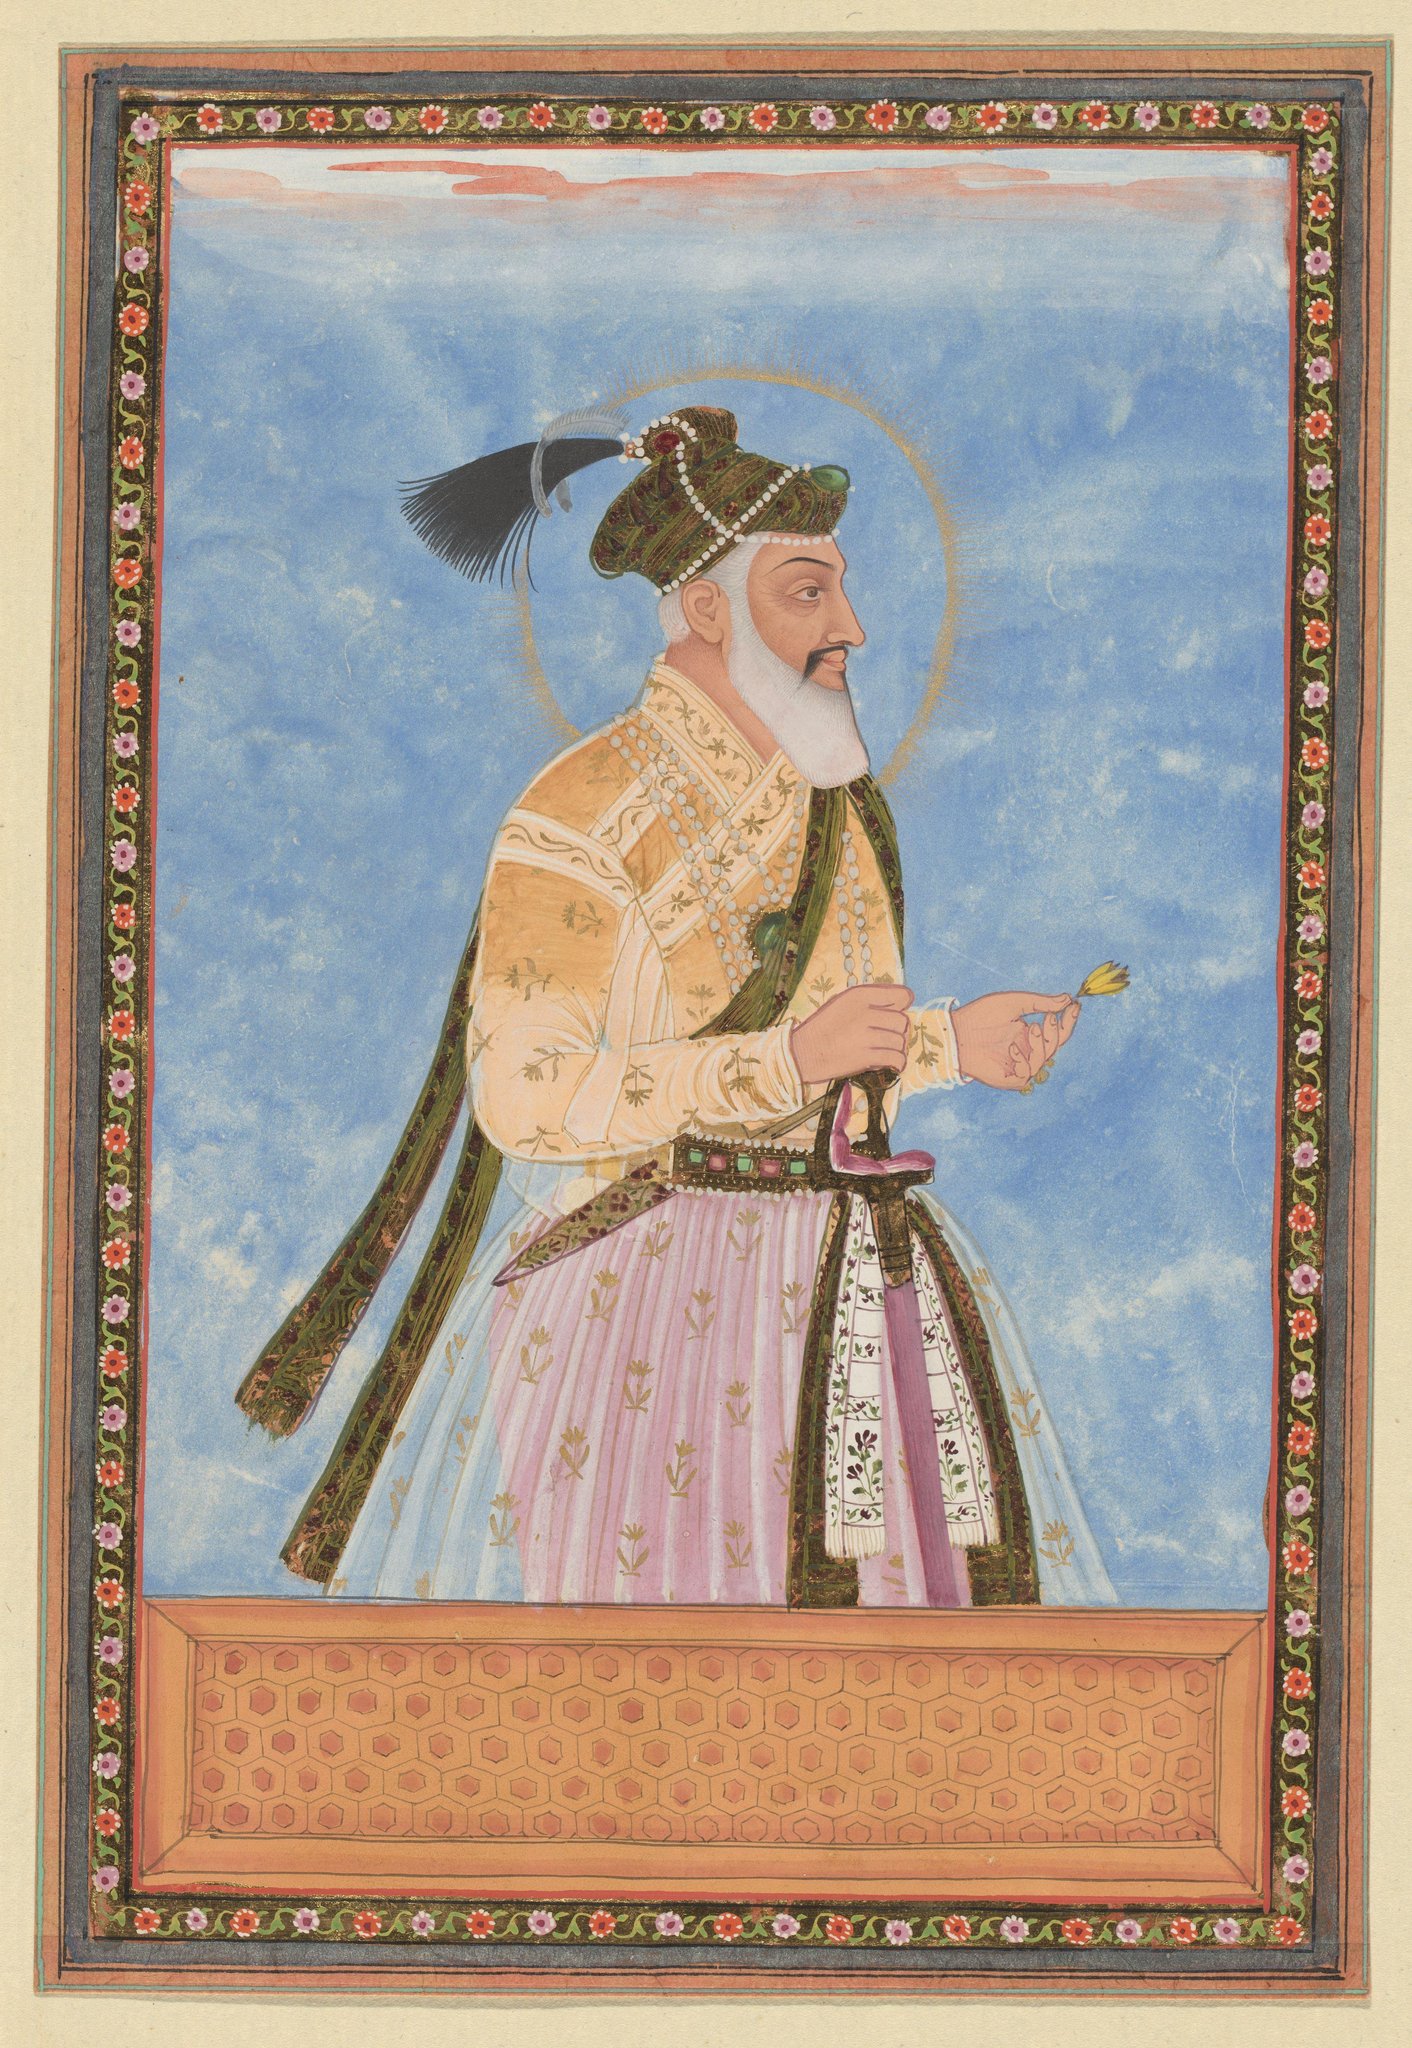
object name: drawing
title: Portret van Shah Jahan Padshah, de zoon van Jihangir, die na zijn vader regeerde in Hindustan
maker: Anonymous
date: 1686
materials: paint, gold leaf, gouache, paper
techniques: brush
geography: golkonda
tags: amsterdam, print maker, mayor, nicolaes cornelisz. witsen, historical person (...) - historical person (...) portrayed alone, ruler, sovereign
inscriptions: annotation: ‘Stah Giehan Zoon van Giehankjir, Koning van Hindostan’, collector's mark: Lugt 1838, collector's mark: Lugt 240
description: Shah Jahan Padshah, met witte baard, is tot aan zijn heupen afgebeeld, naar rechts gewend, met een zwaard in de rechter hand en een bloem in de linker hand. Blad 5 in het `Witsen-Album', met 49 Indiase miniaturen van vorsten. Boven het portret een stukje papier met de naam in het Perzisch. Onder het portret een stukje papier met de naam in het Portugees.